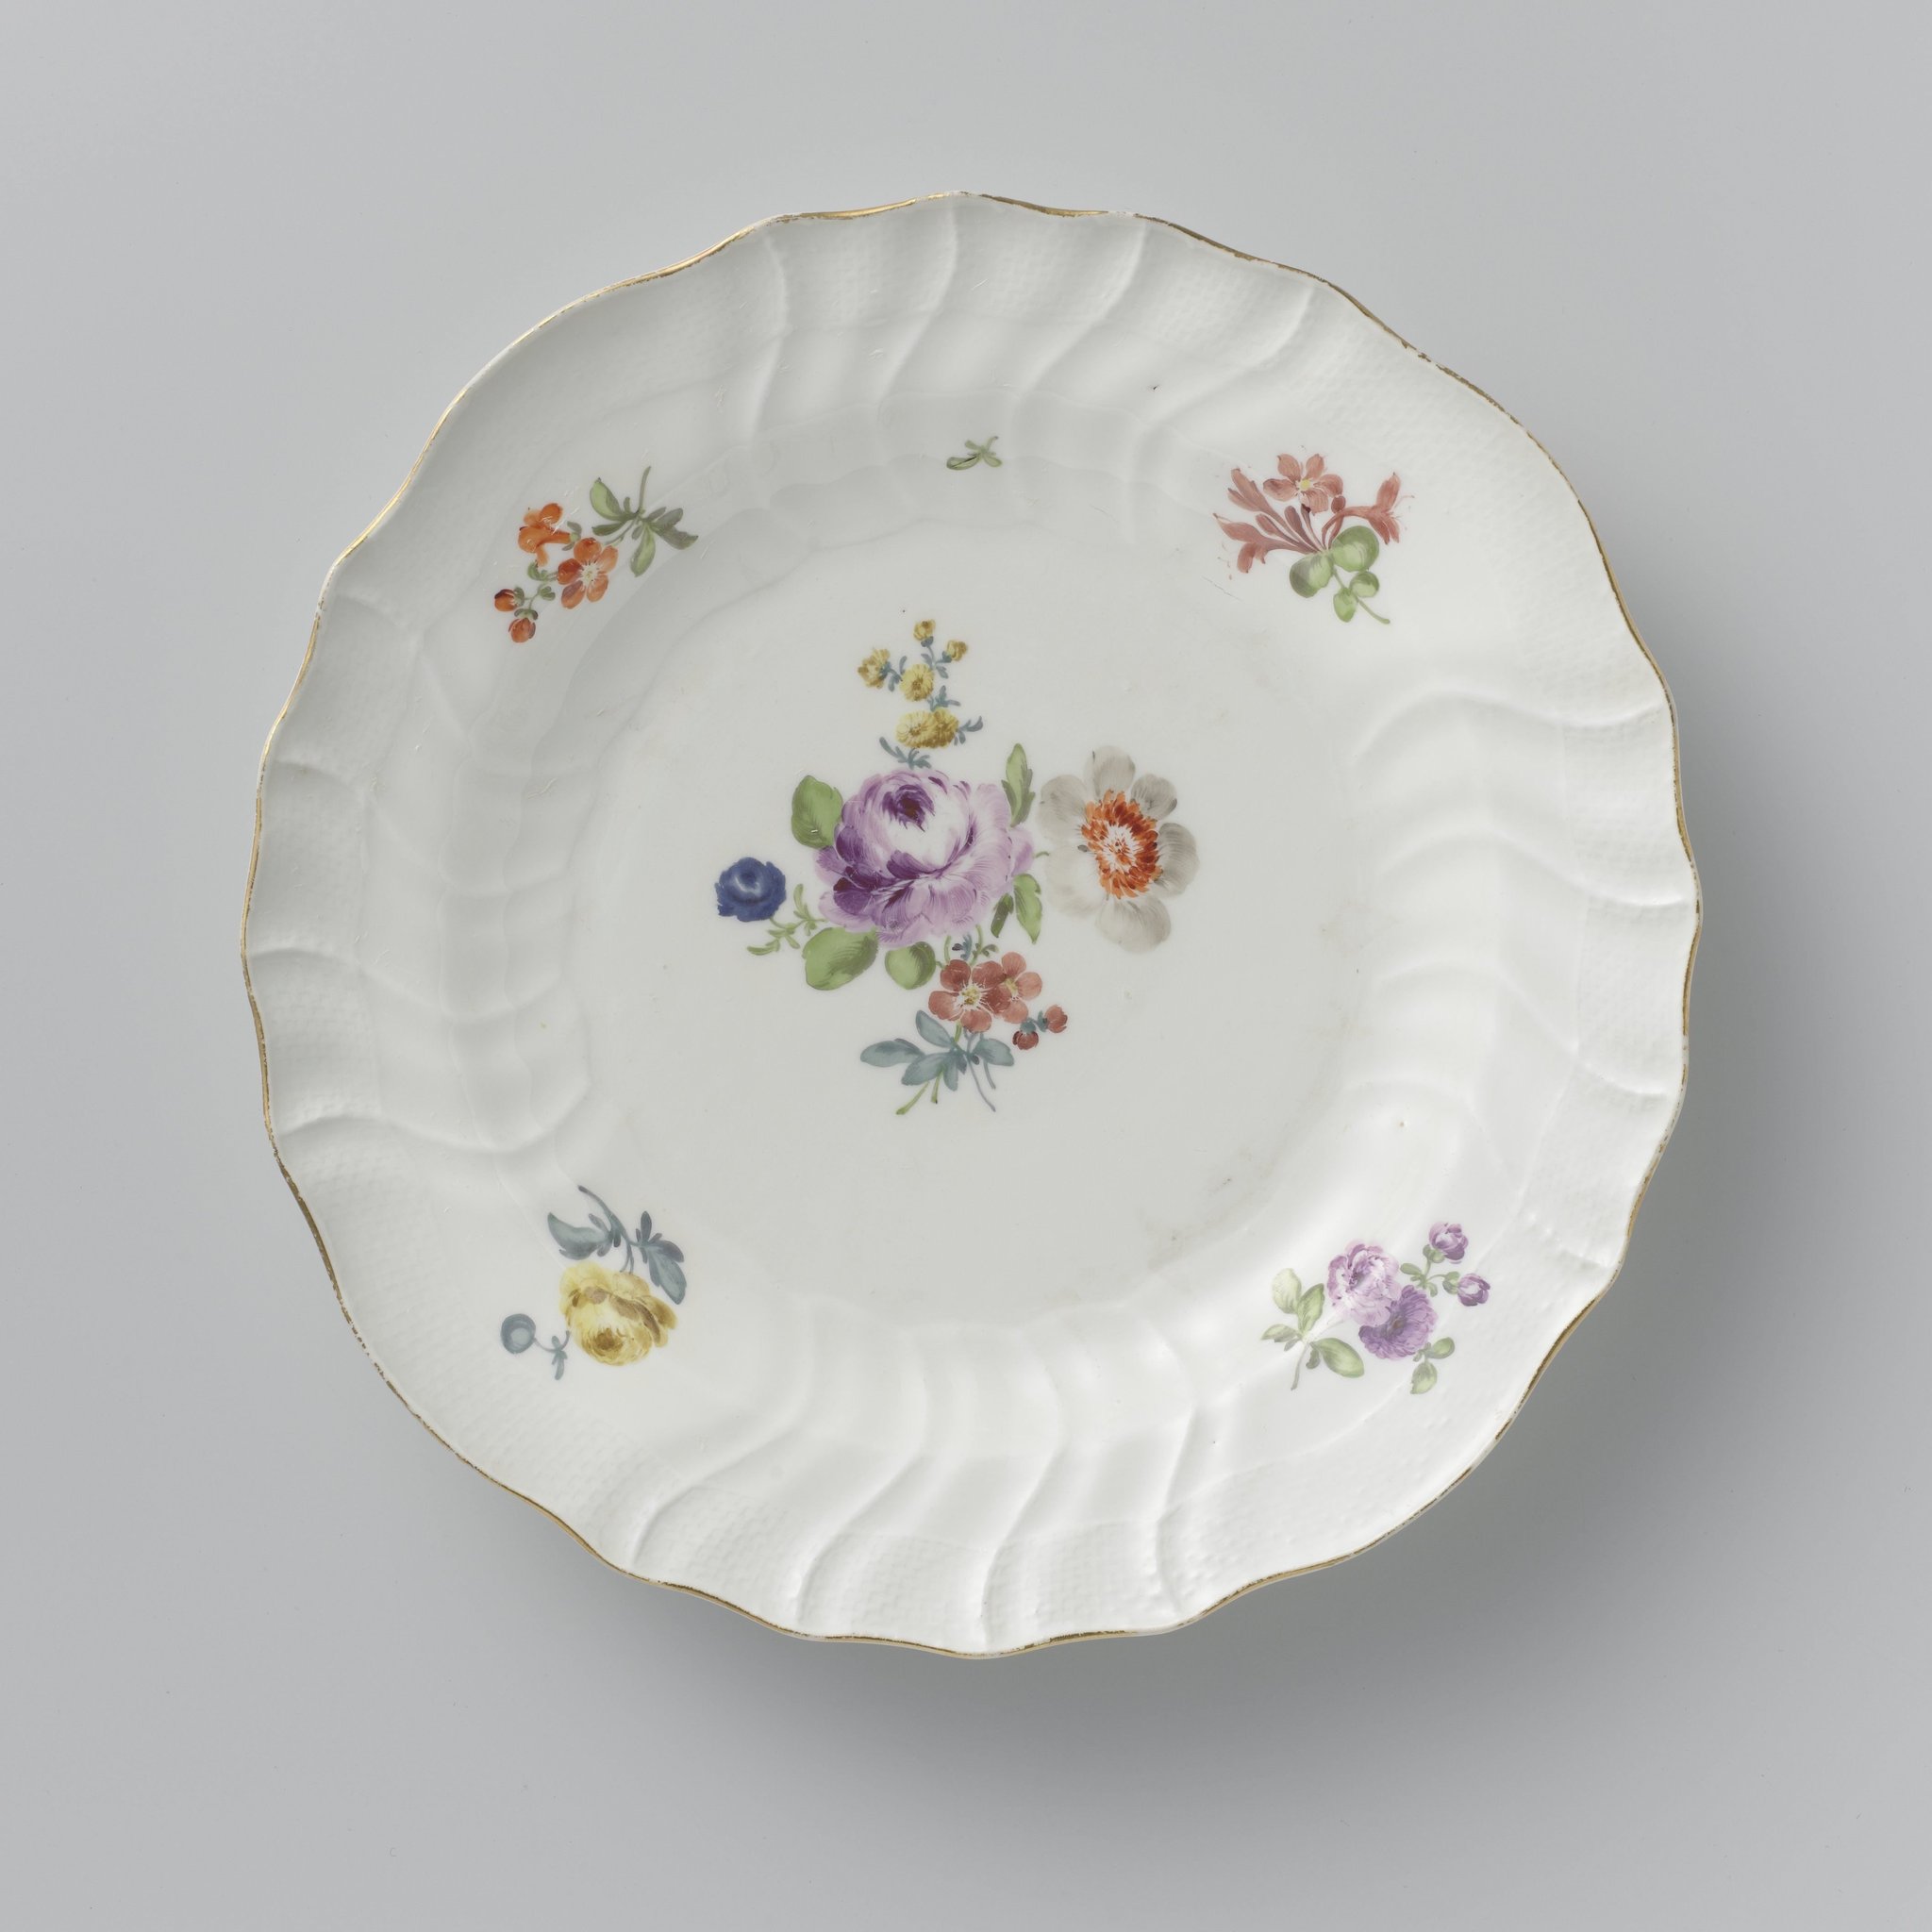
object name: eating drinking utensil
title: Bord, veelkleurig beschilderd met Deutsche Blumen, insekten en vruchten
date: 1750-1760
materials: porcelain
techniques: painted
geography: meissen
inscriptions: factory mark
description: Rond bord van beschilderd porselein. Het bord is beschilderd met Deutsche Blumen, insekten en vruchten. De rand is in reliëf versierd met het Neuozier-patroon. Het bord is gemerkt en hoort bij een servies (BK-17474-1 t/m BK-17474-253).